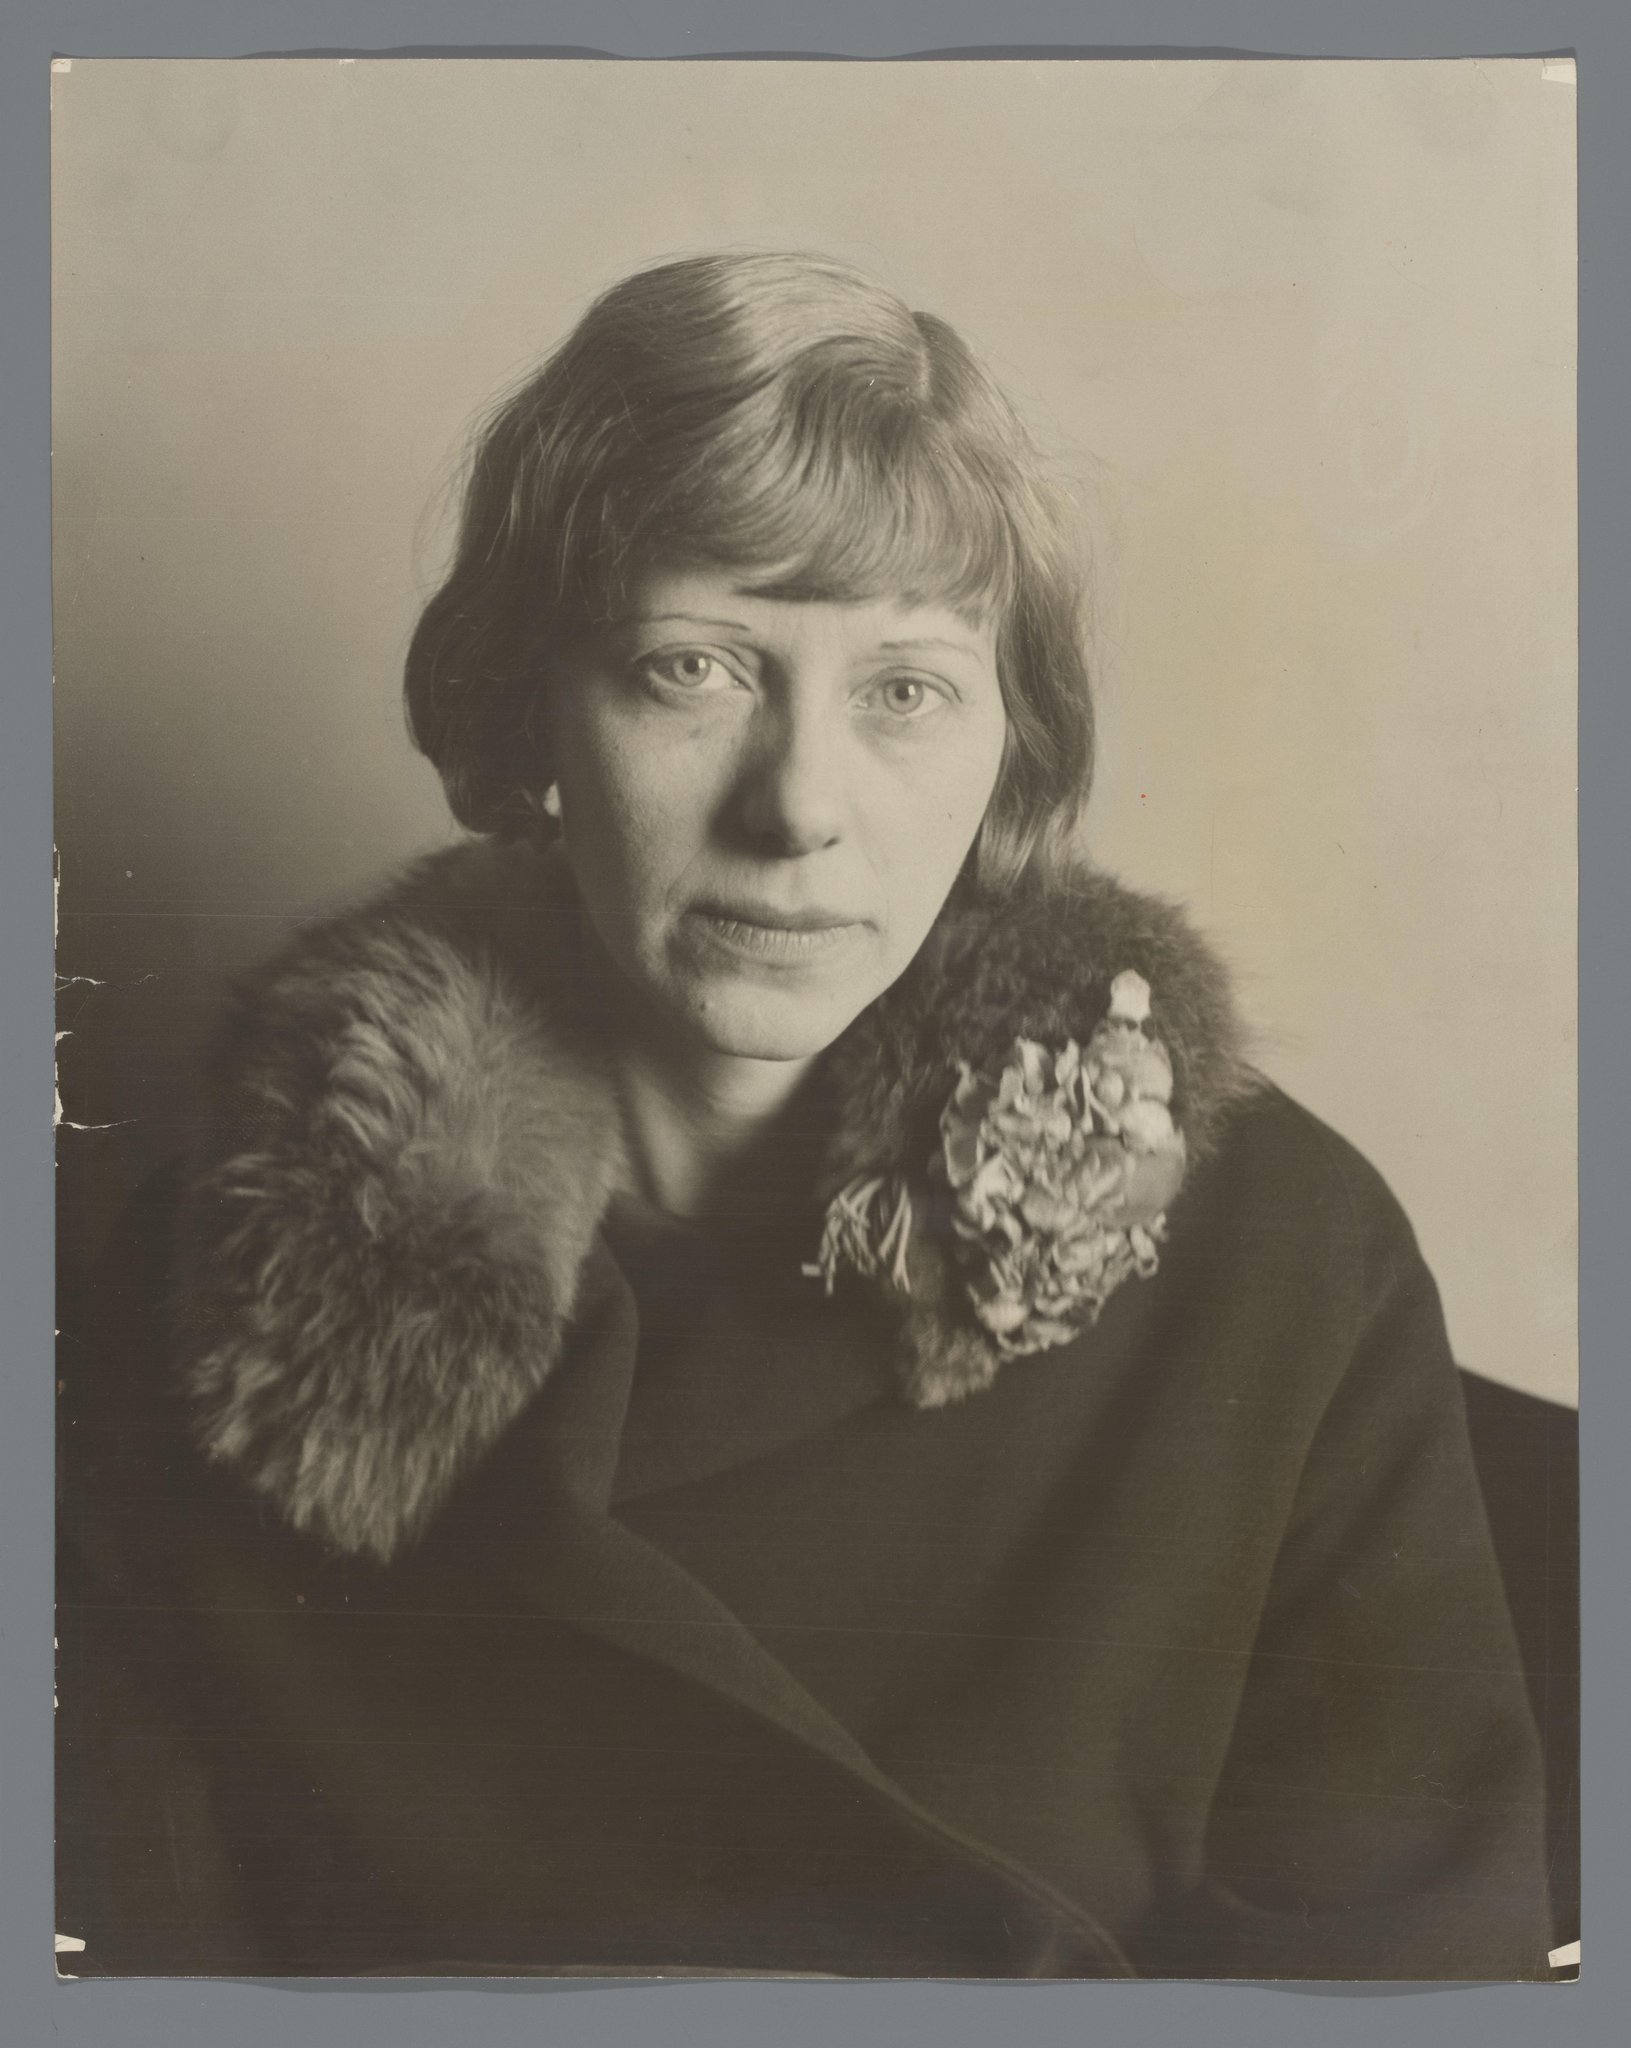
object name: photograph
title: Portret van de weduwe van Clarence Ivy Toms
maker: Anonymous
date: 1925-1928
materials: paper, photographic support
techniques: gelatin silver print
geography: united states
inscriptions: annotation: ‘Mrs C Ivy Toms widow of druggist killed by Hickman’, annotation: ‘9-’, stamp: ‘REFERED E. DEPT. FEB 25 28 N.E.A.’, annotation: ‘179199’, annotation: ‘696’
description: Clarence Ivy Toms, drogist in Rosehill, CA, in 1926 vermoord door William Edward Hickman.